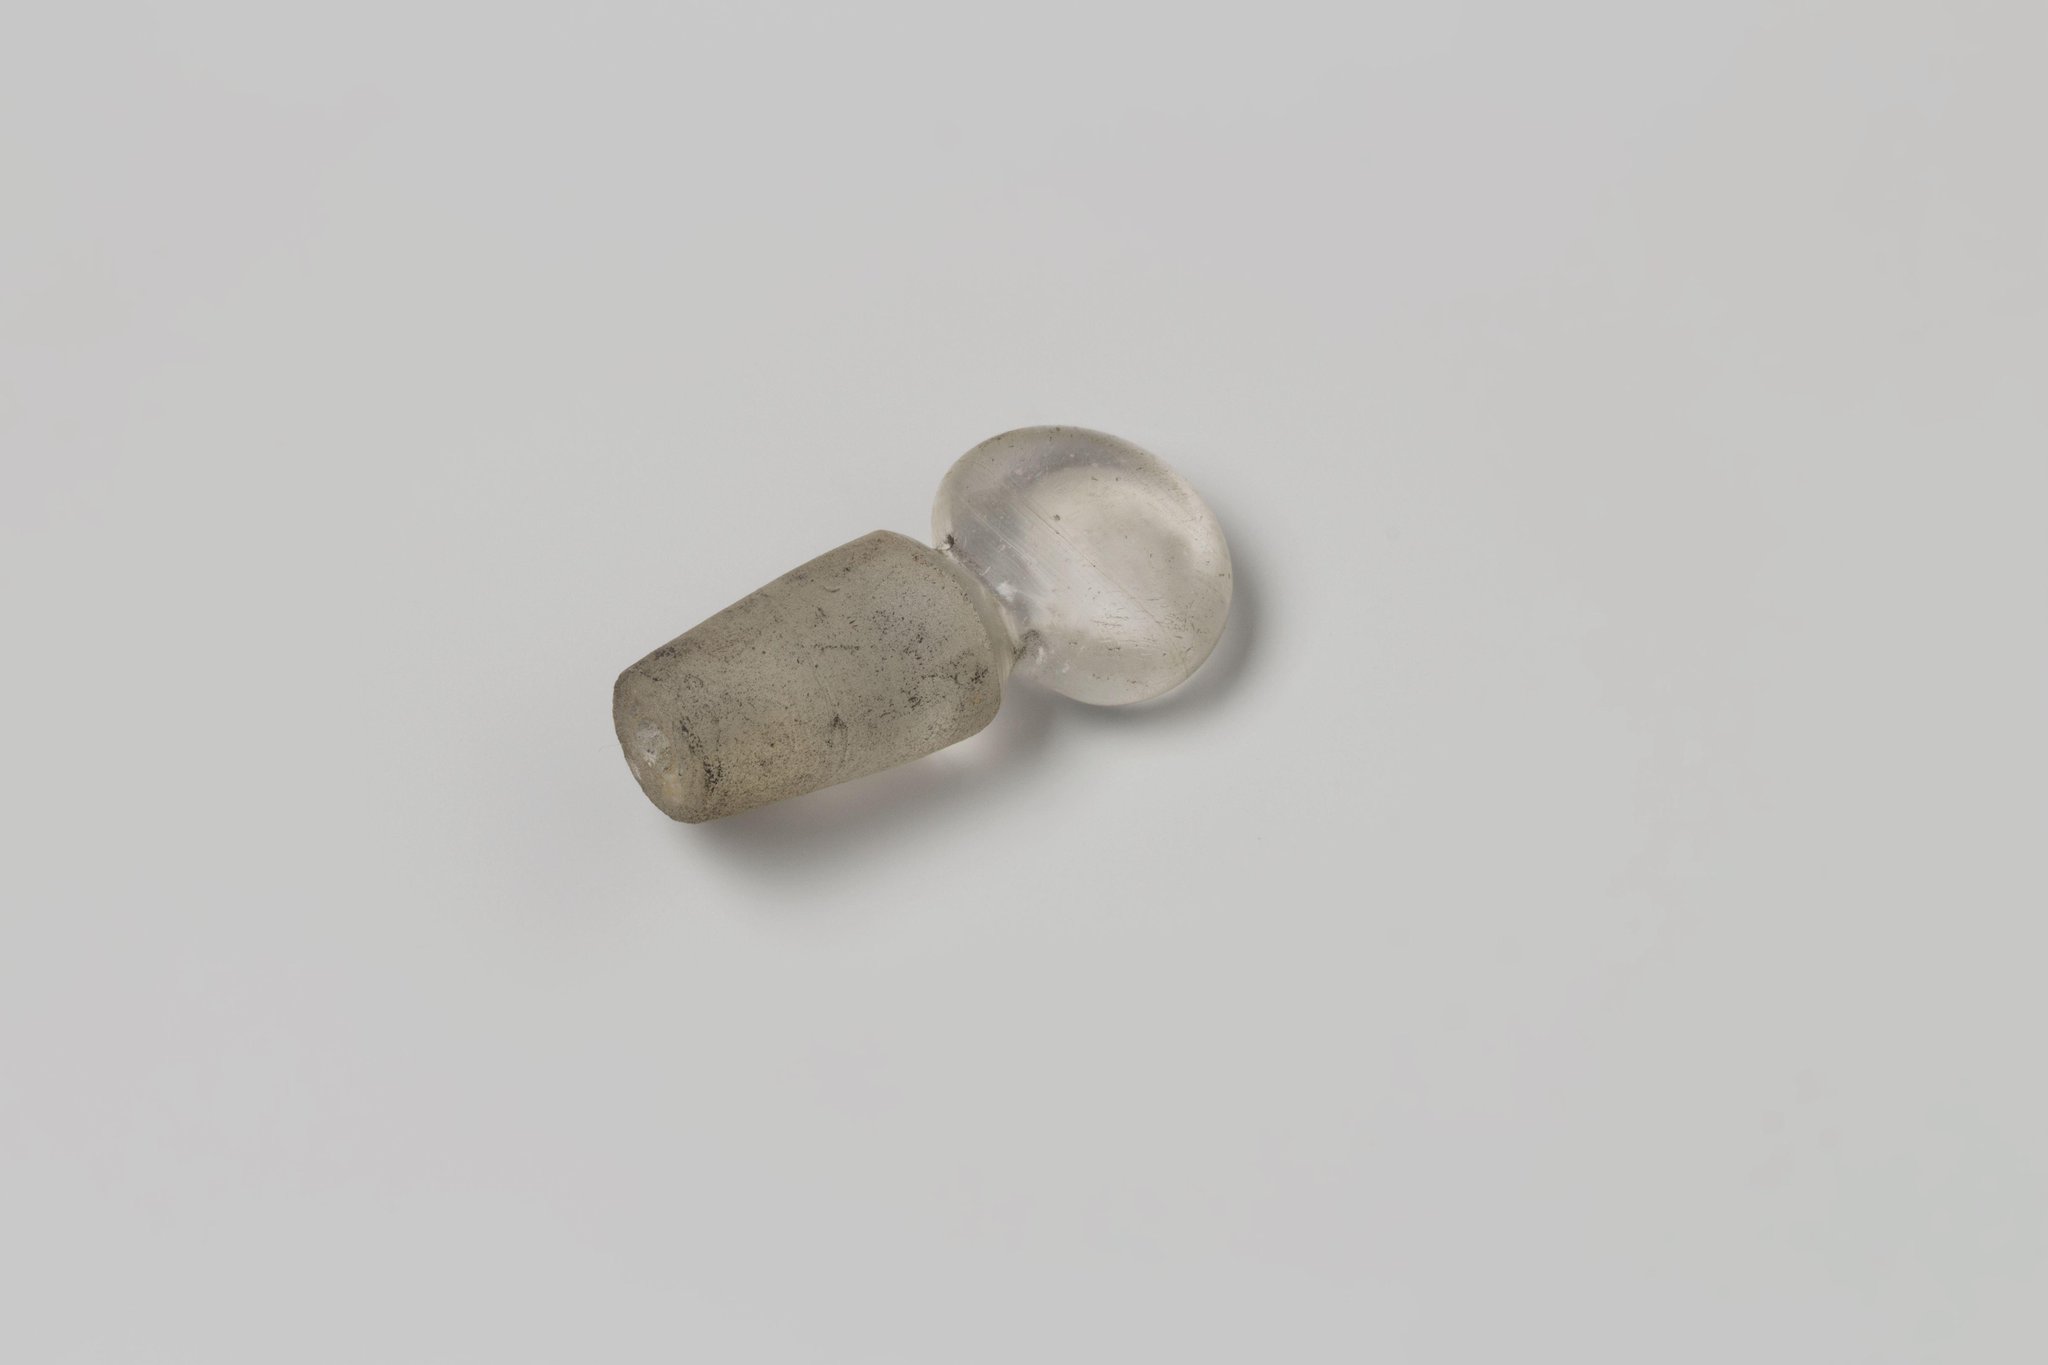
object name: vessel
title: Stop van vaatwerk uit het wrak van de Oost-Indiëvaarder Hollandia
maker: Anonymous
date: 1700-1743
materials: glass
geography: netherlands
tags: verenigde oostindische compagnie, hollandia (schip), annet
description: Vessel part, stopper; id. NG 1979-527H, cylinder hollow.